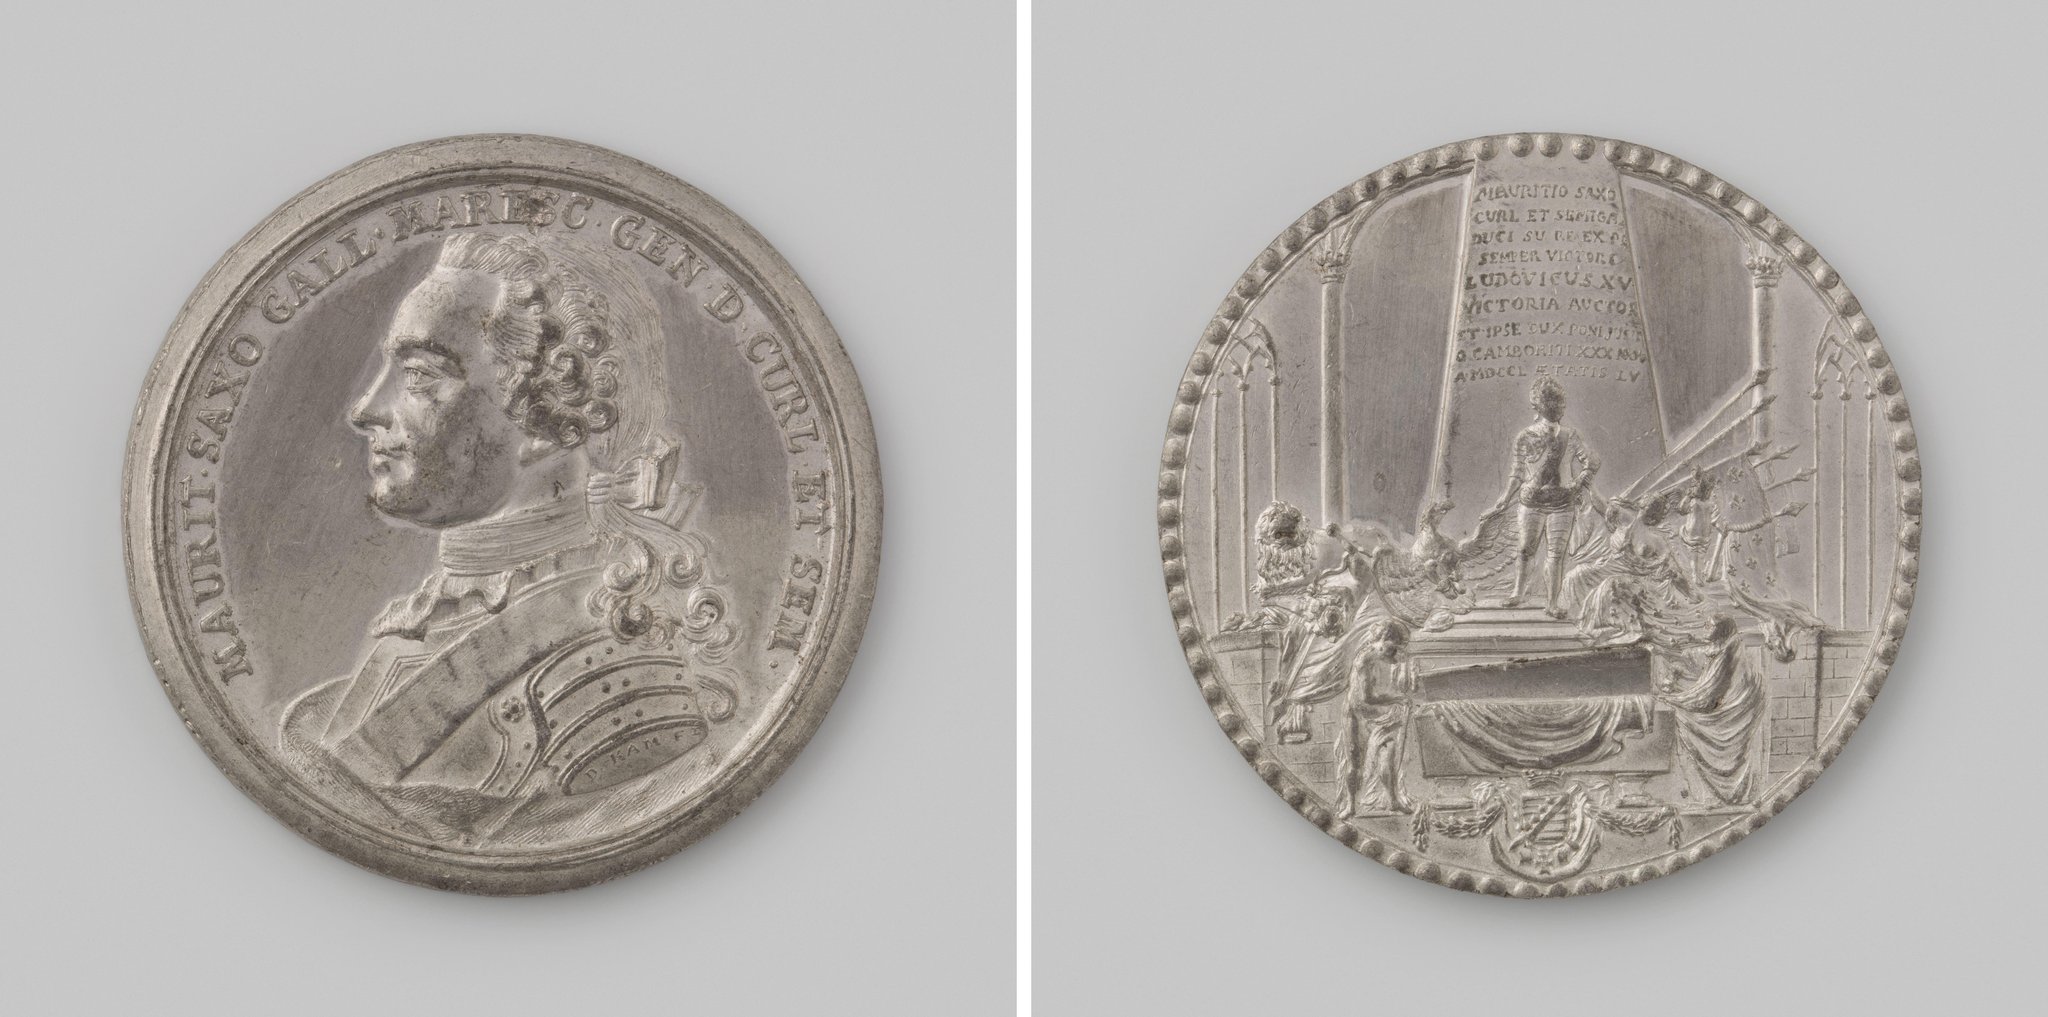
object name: history medal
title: Overlijden van Maurits van Saksen 1750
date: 1750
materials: tin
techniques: striking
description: Tinnen penning, op de voorzijde het borstbeeld van Maurits naar links met omschrift, op de keerzijde rouwende mensen rond een grafmonument met tombe.